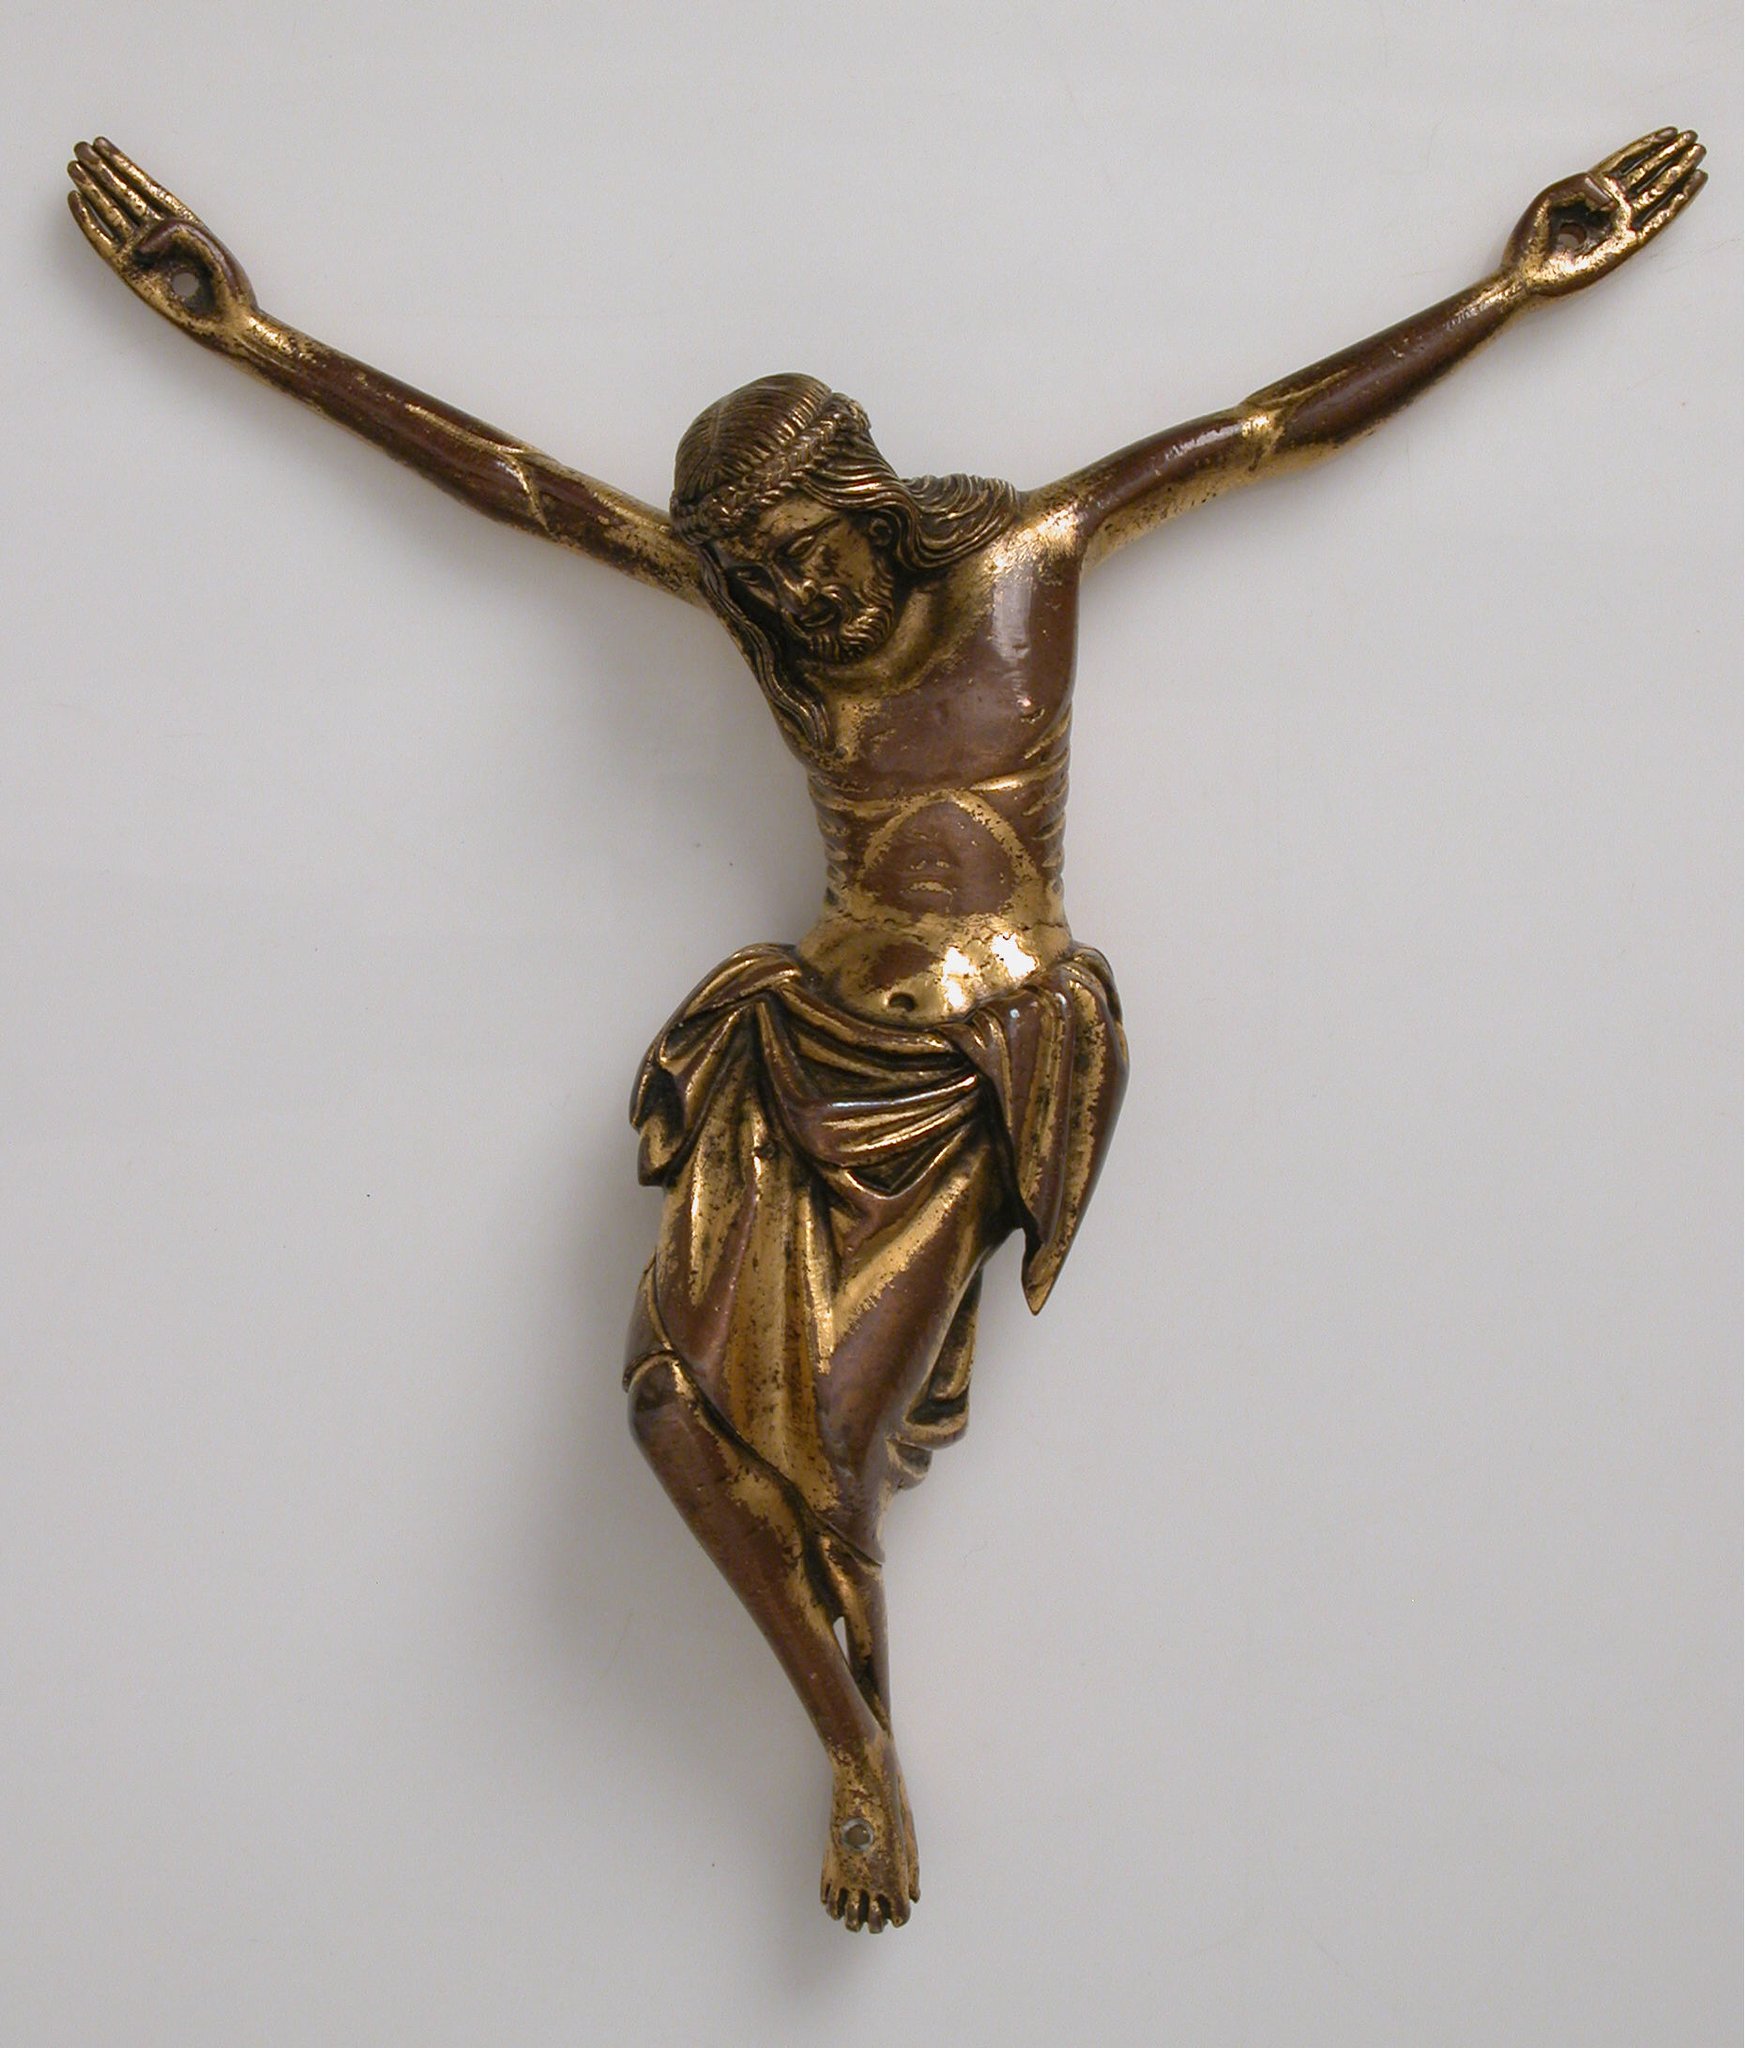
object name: corpus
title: Crucified Christ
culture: italian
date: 1351-1400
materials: copper alloy, gilt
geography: italy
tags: crucifixion